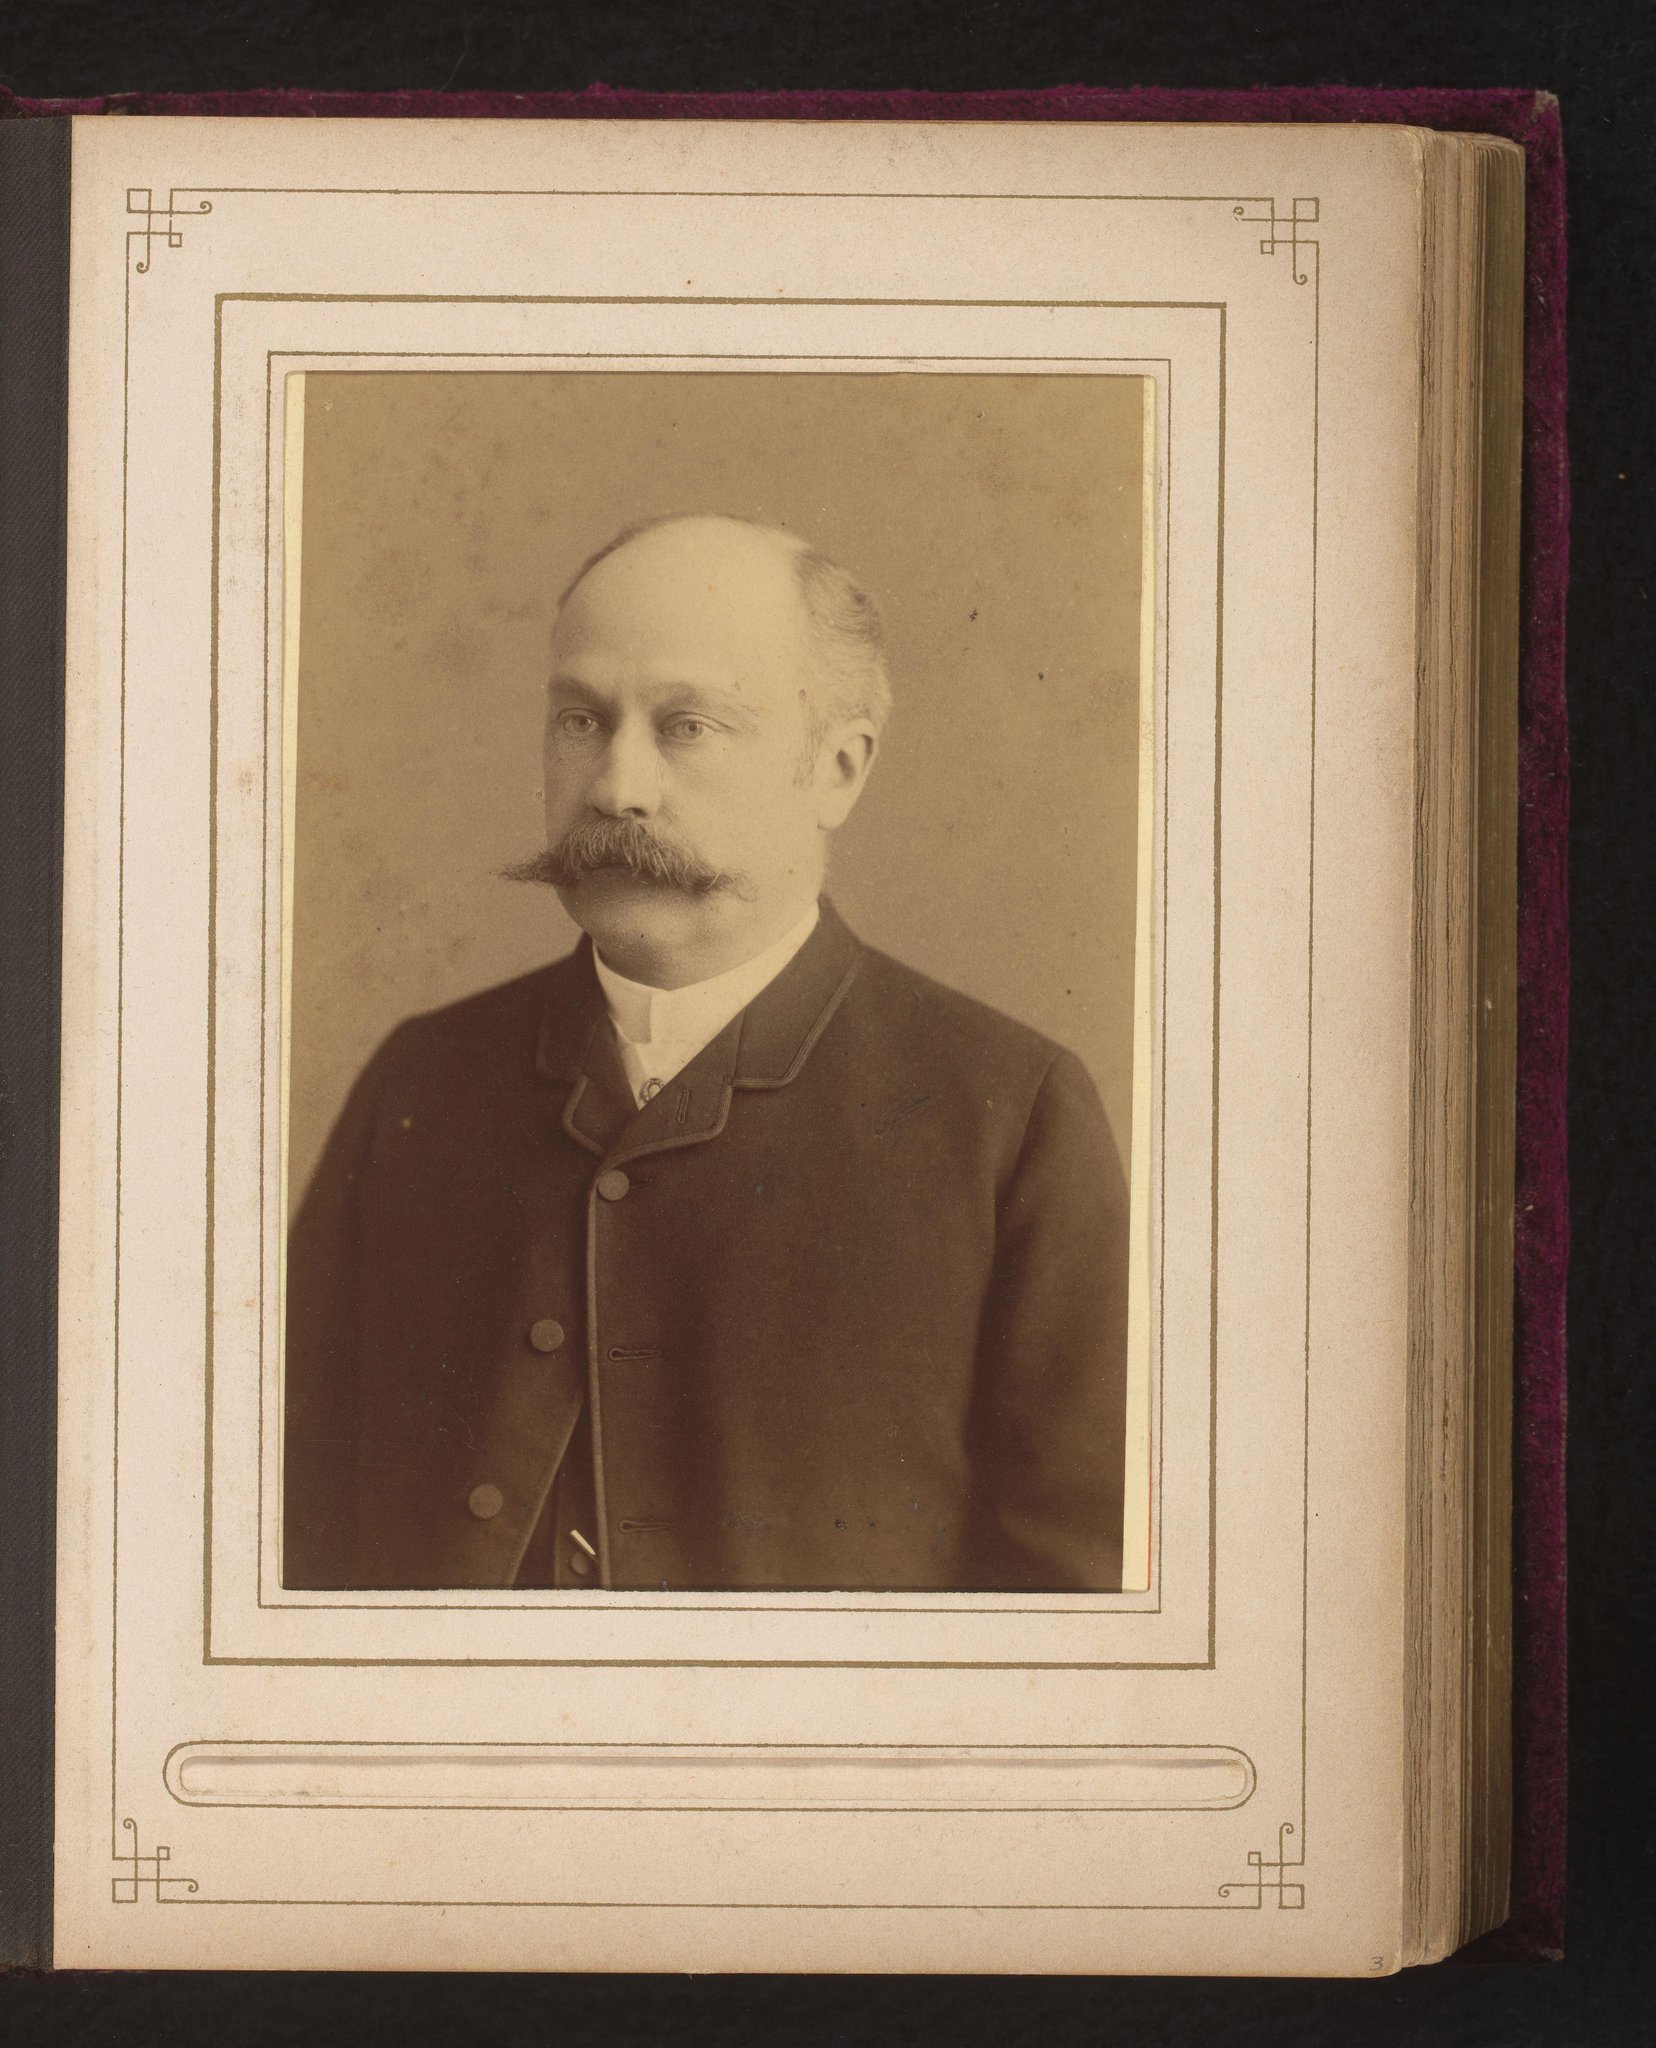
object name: album leaf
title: Portret van een man met snor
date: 1865-1903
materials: cardboard, photographic support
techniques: albumen print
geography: the hague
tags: moustache, historical persons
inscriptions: inscription: ‘De Lavieter & Co./ PHOTOGRAPHES DE S. M. LE ROI,/ DE S. A. R. LE PRINCE D'ORANGE/ ET DE S.A.R.MADME LA PRINCESSE HENRI/ DES PAYS-BAS./ LA HAYE./ 2a WILLEMSTRAAT./ Maison spéciale pour agrandissements.’